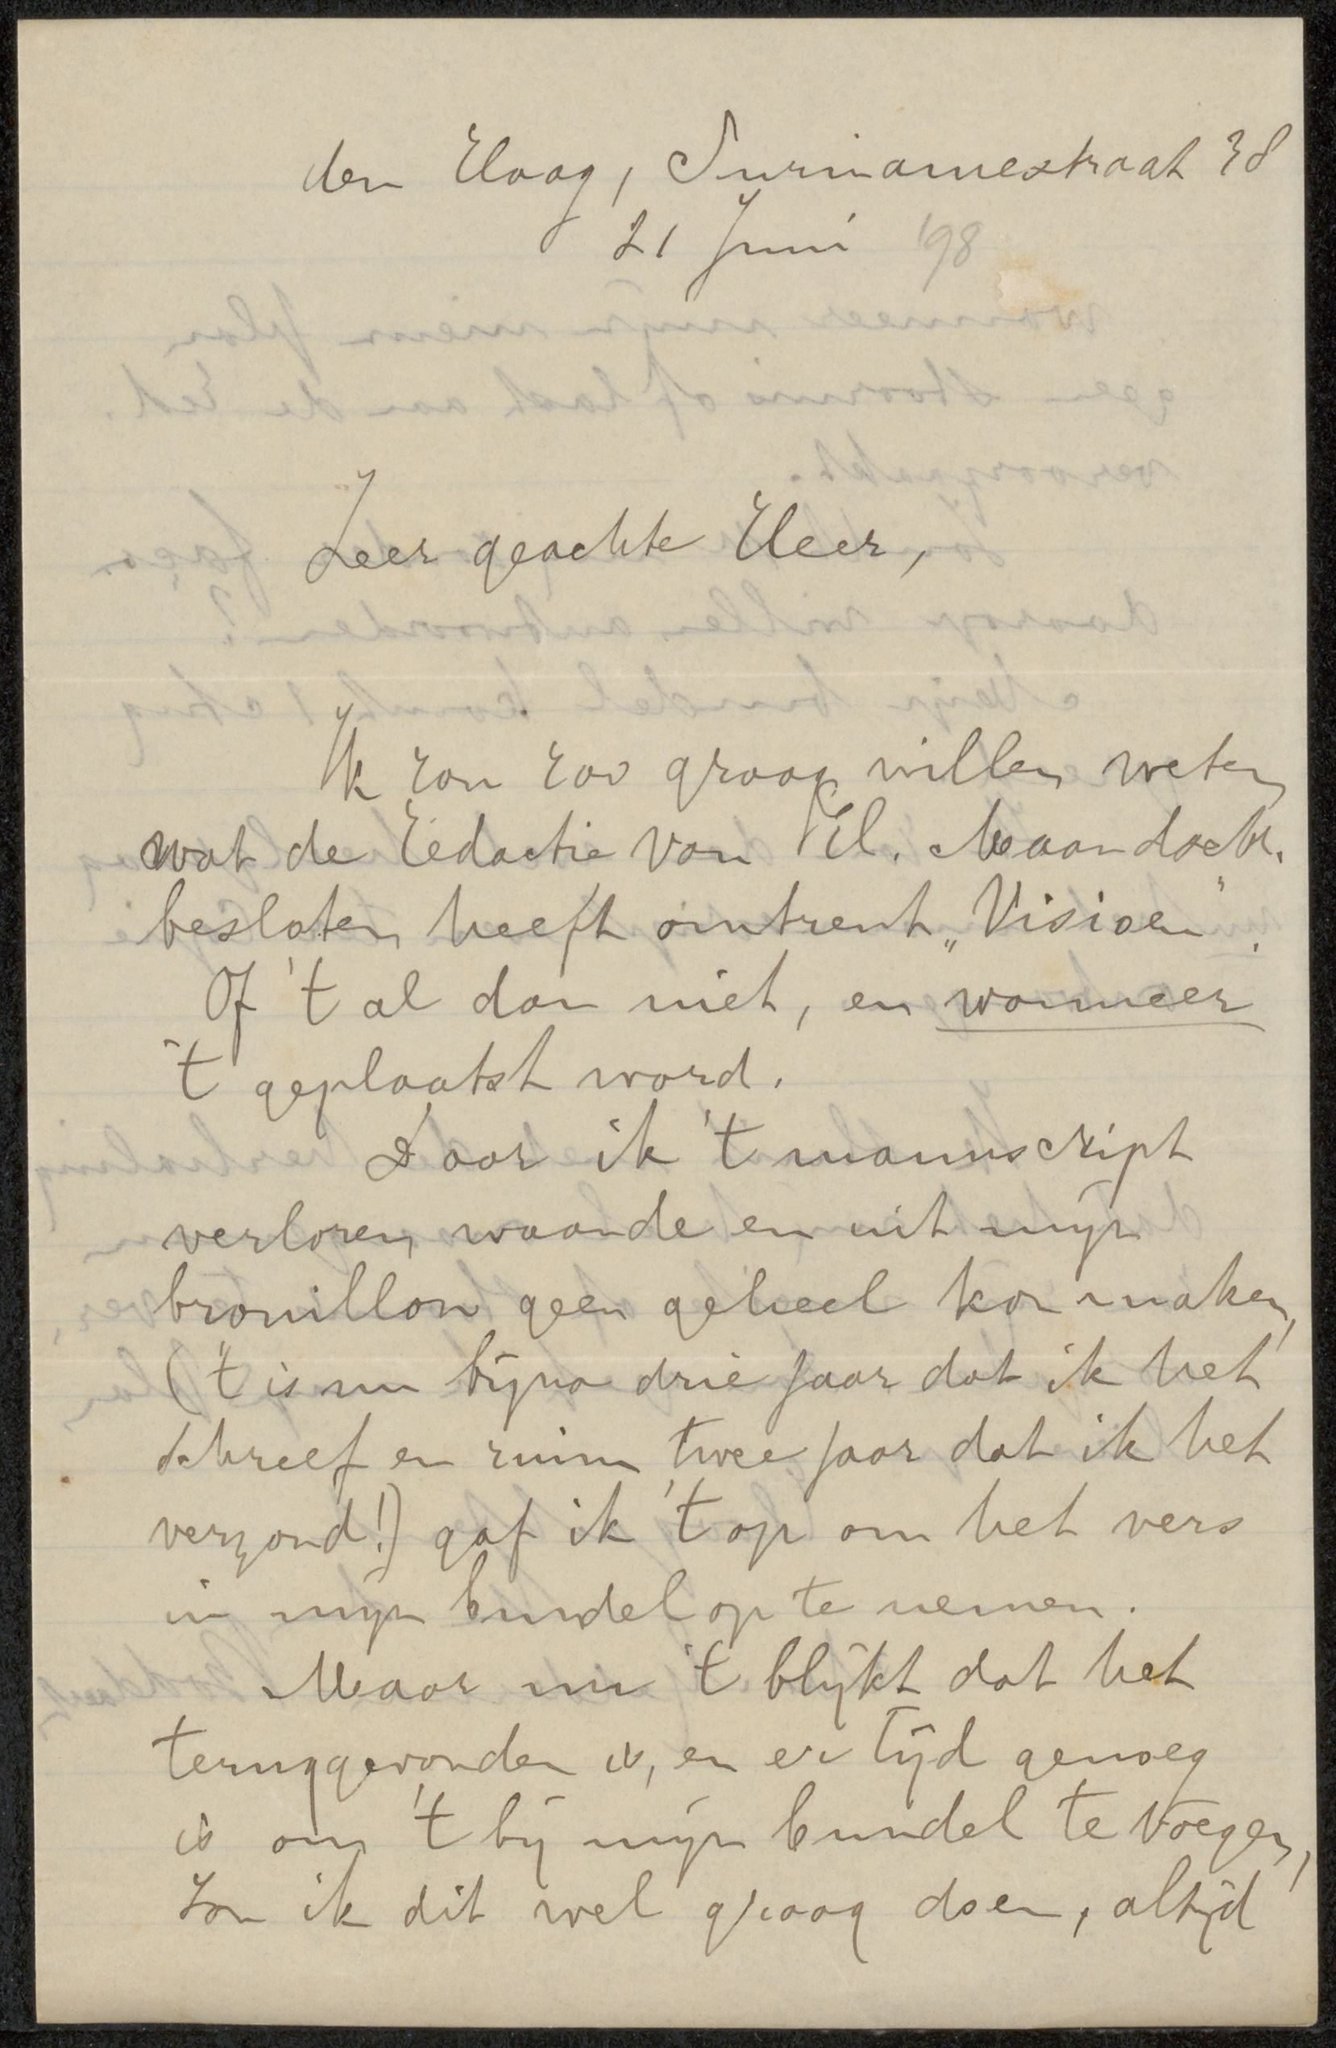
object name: letter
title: Brief aan Philip Zilcken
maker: jonkvrouw marie agathe gelderman-boddaert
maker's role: dichter, schrijver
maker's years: 1844-1914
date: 1898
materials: ink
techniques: pen, writing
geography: the hague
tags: painter, draughtsman, philip zilcken, literature ~ arts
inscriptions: collector's mark: ‘RPK’